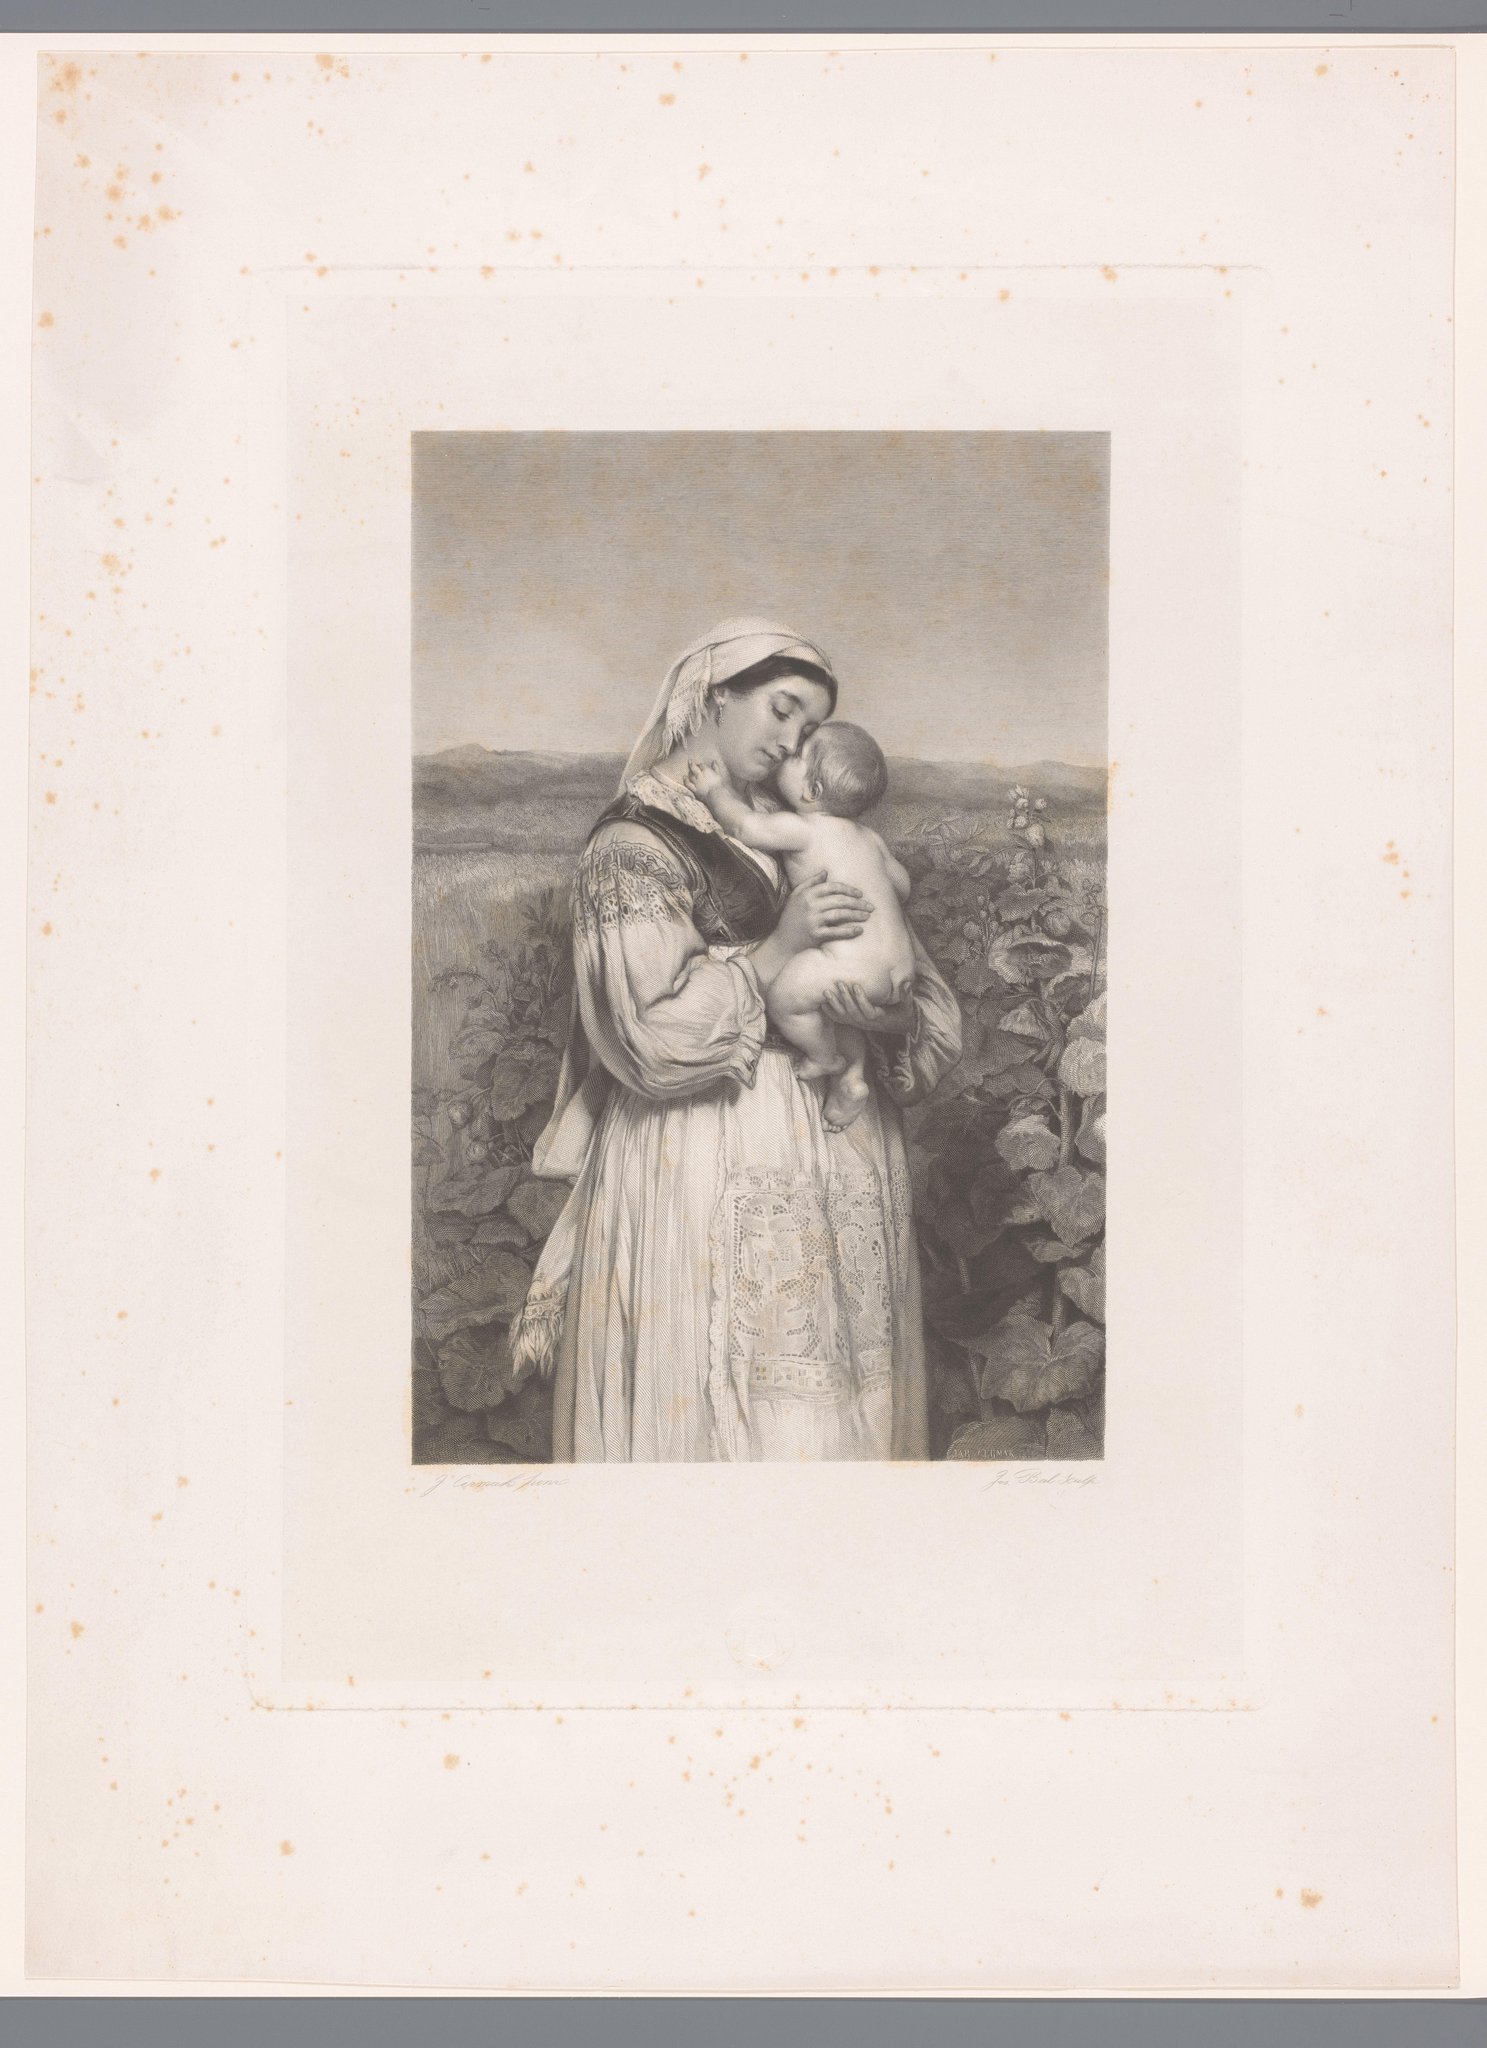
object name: print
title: Moeder met baby in een tuin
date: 1830-1867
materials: paper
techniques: engraving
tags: mother and baby or young child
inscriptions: stamp: ‘Wt jonsten versaemt’